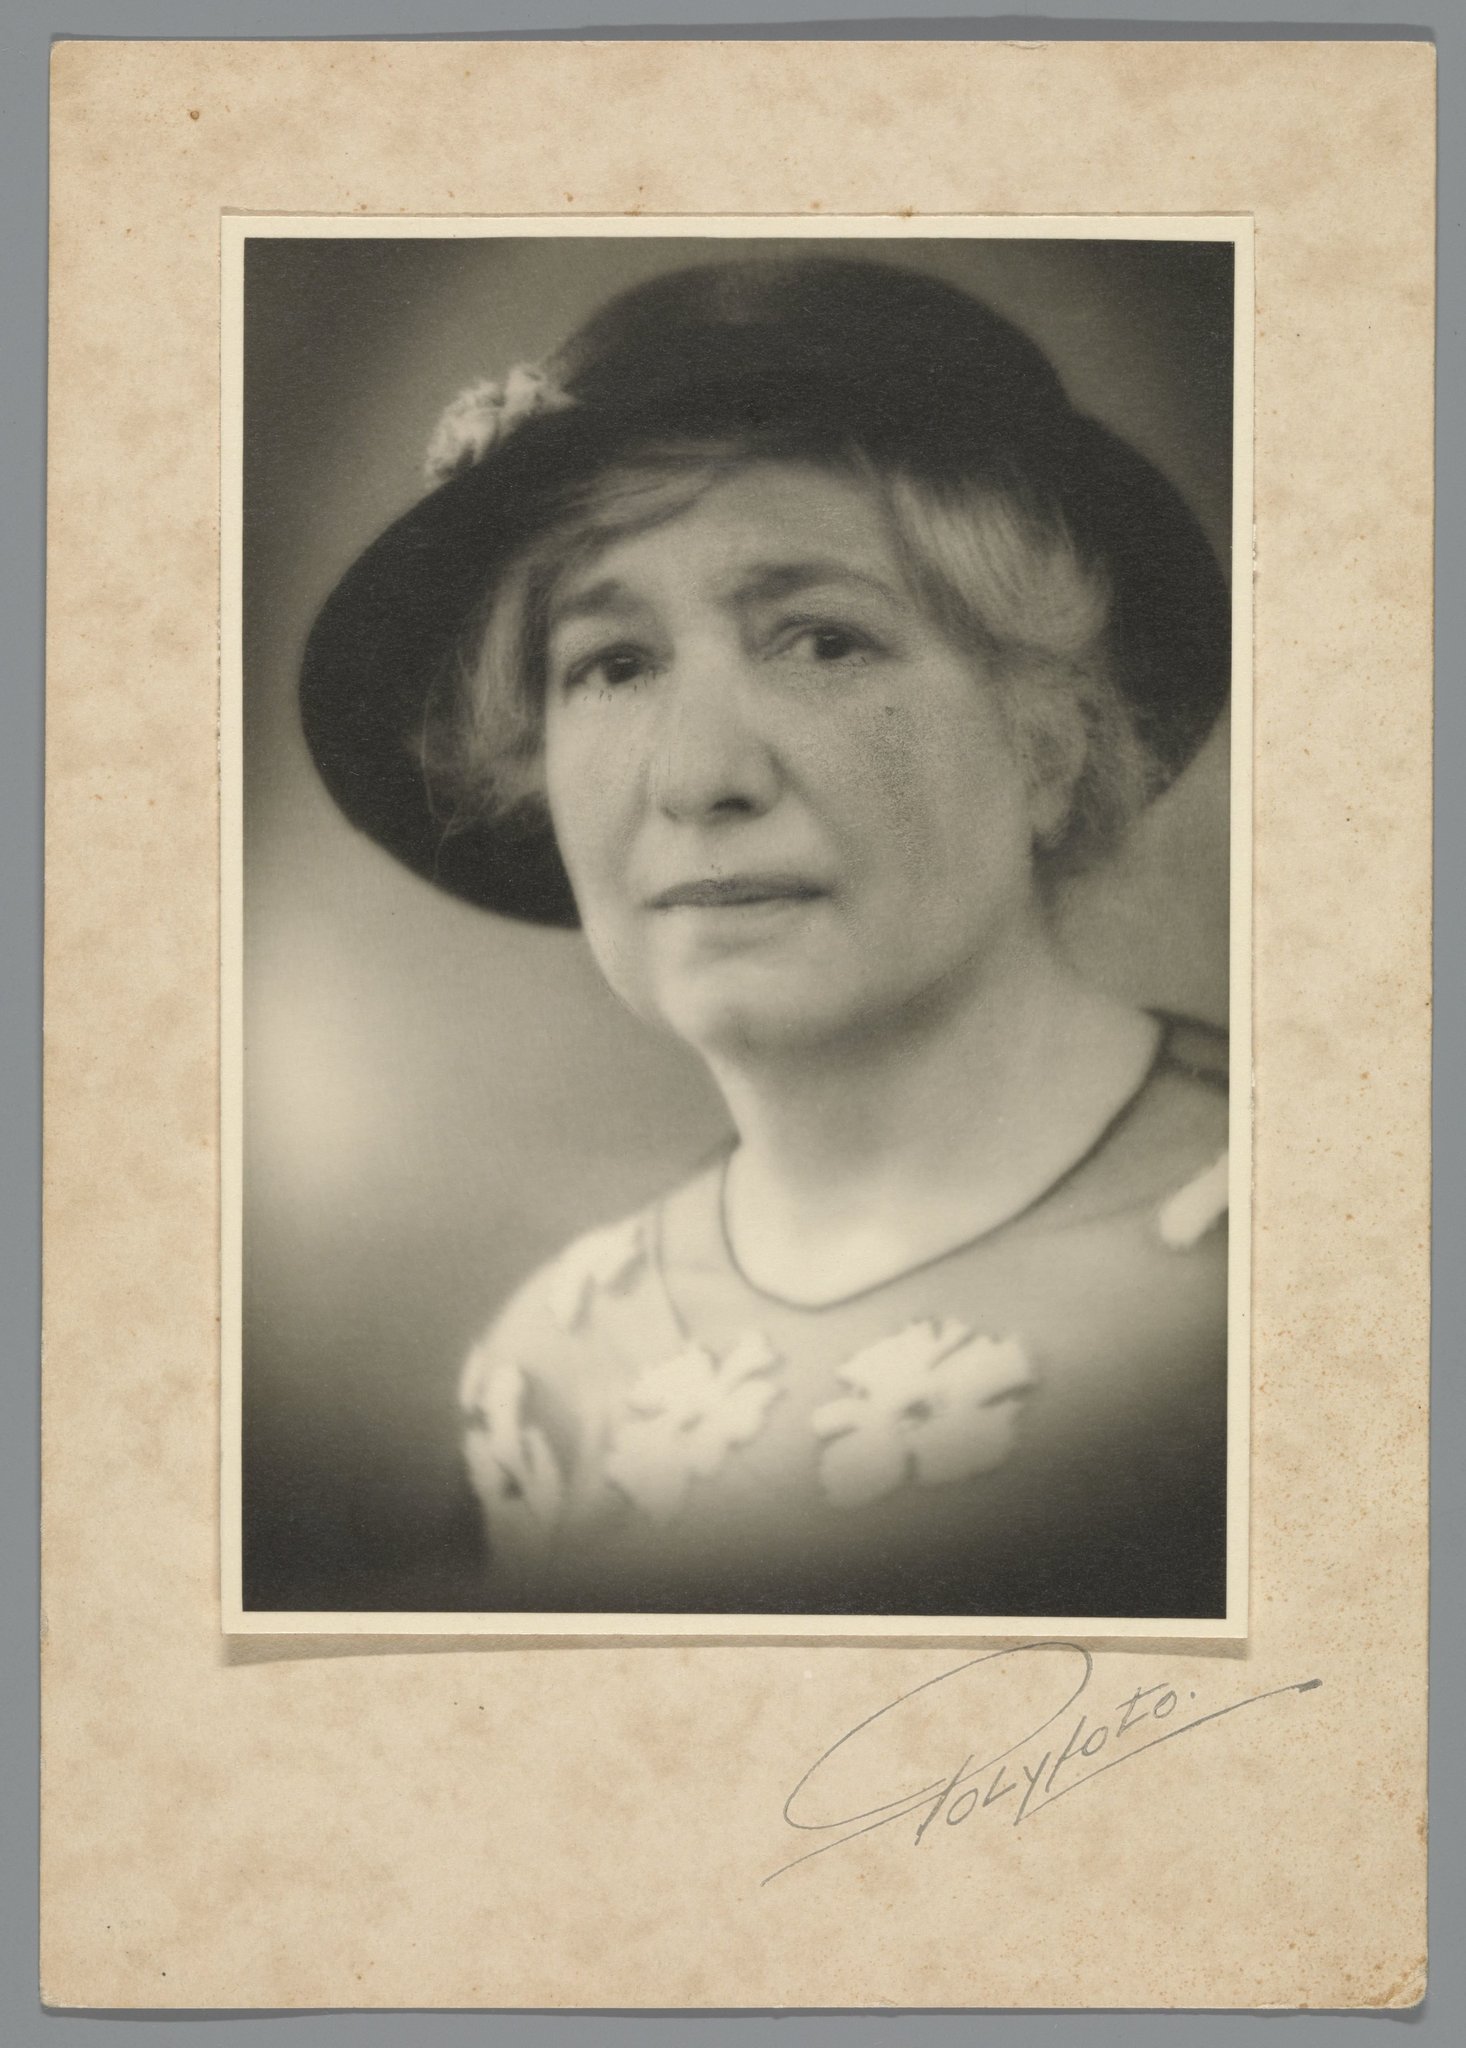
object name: photograph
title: Marie Witsen-Schorr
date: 1860-1915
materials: paper, photographic support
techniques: gelatin silver print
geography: netherlands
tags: amsterdam, augusta maria agnes witsen-schorr